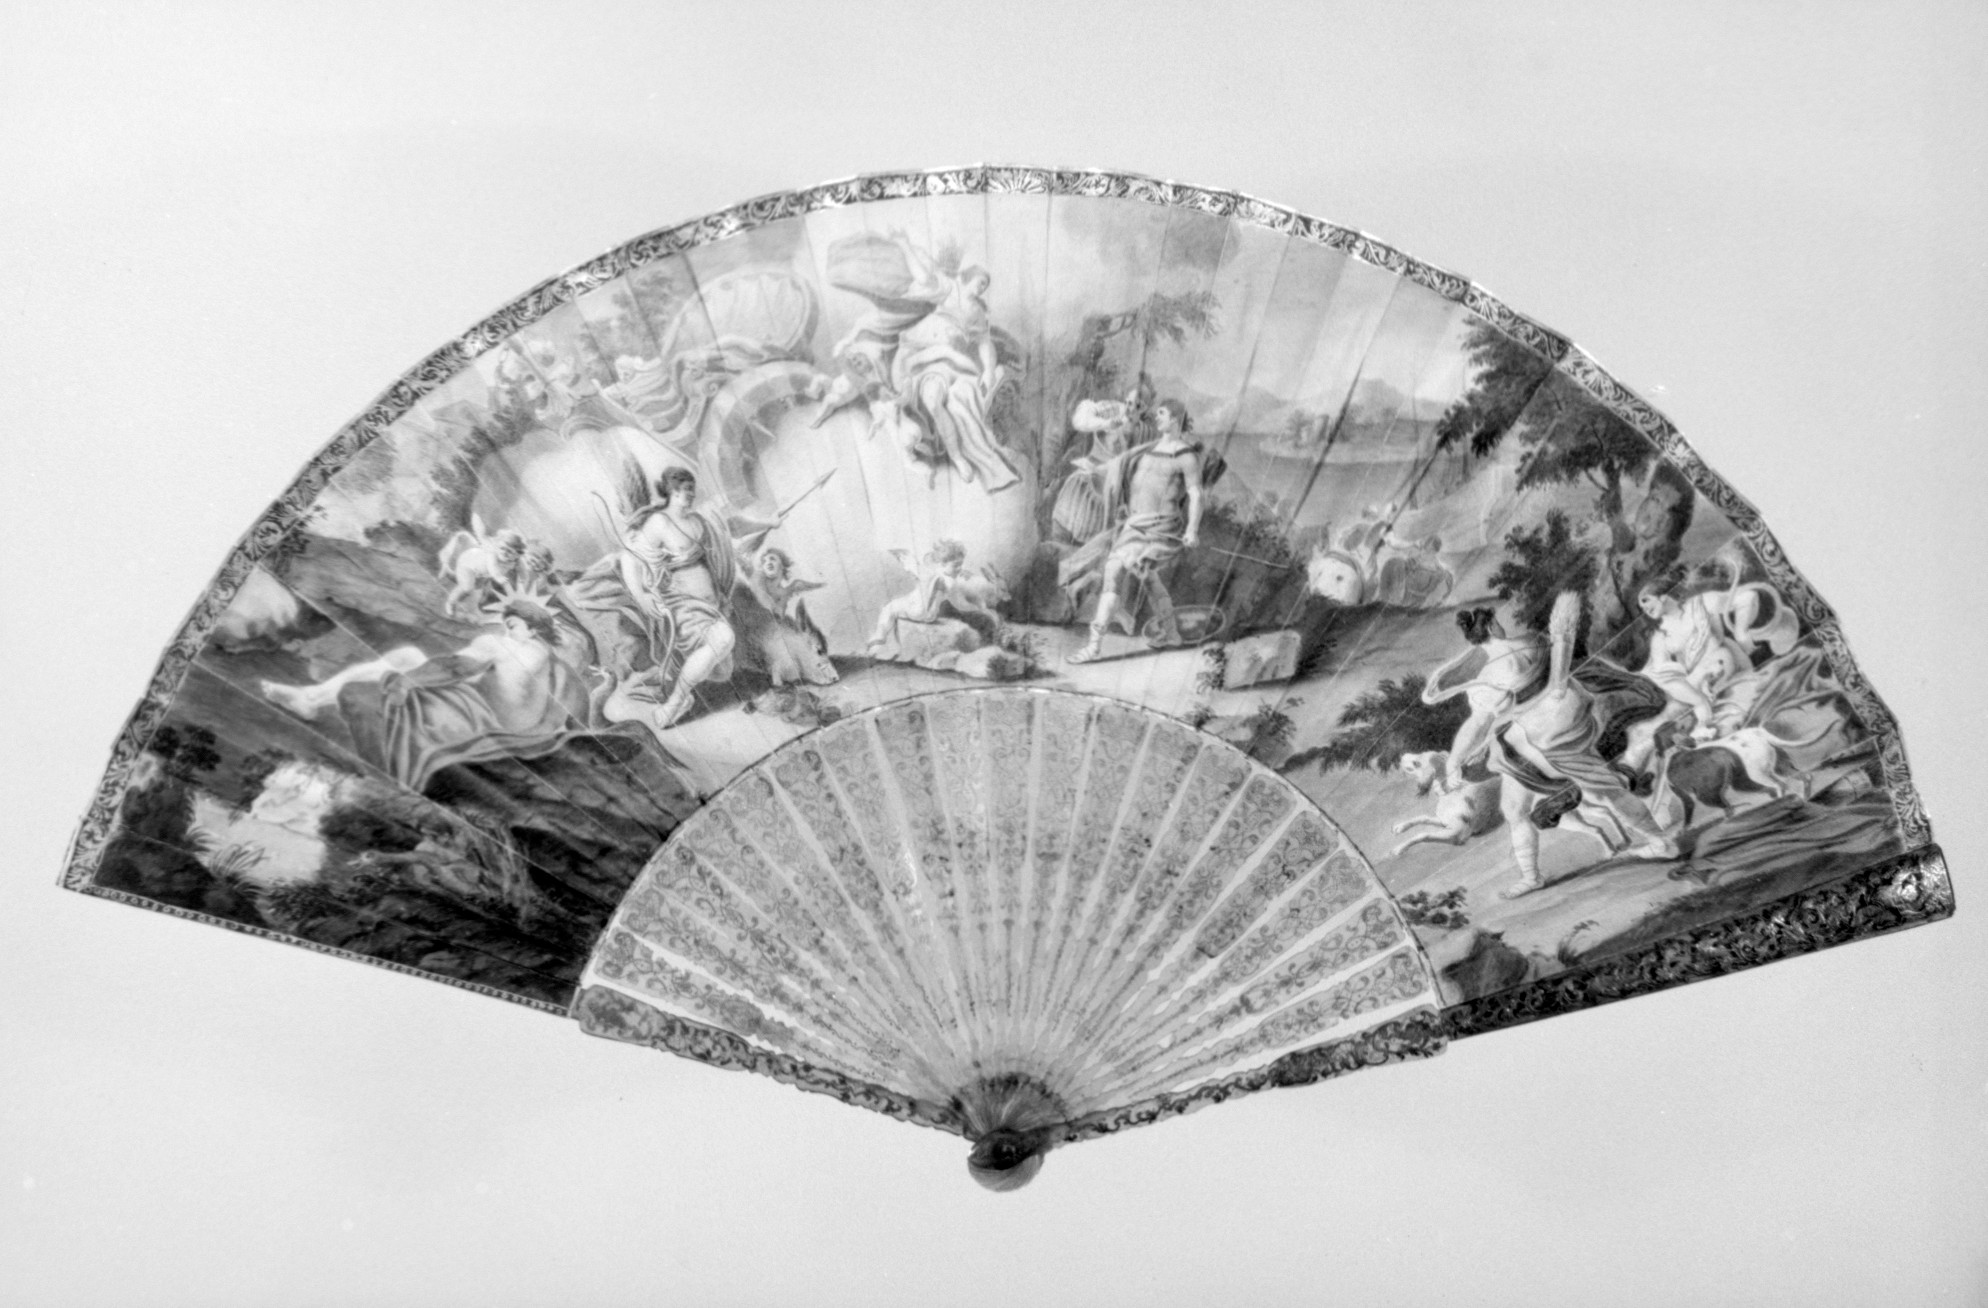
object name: fan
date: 1701-1800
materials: horn, paper, parchment, shell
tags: men,women,dogs